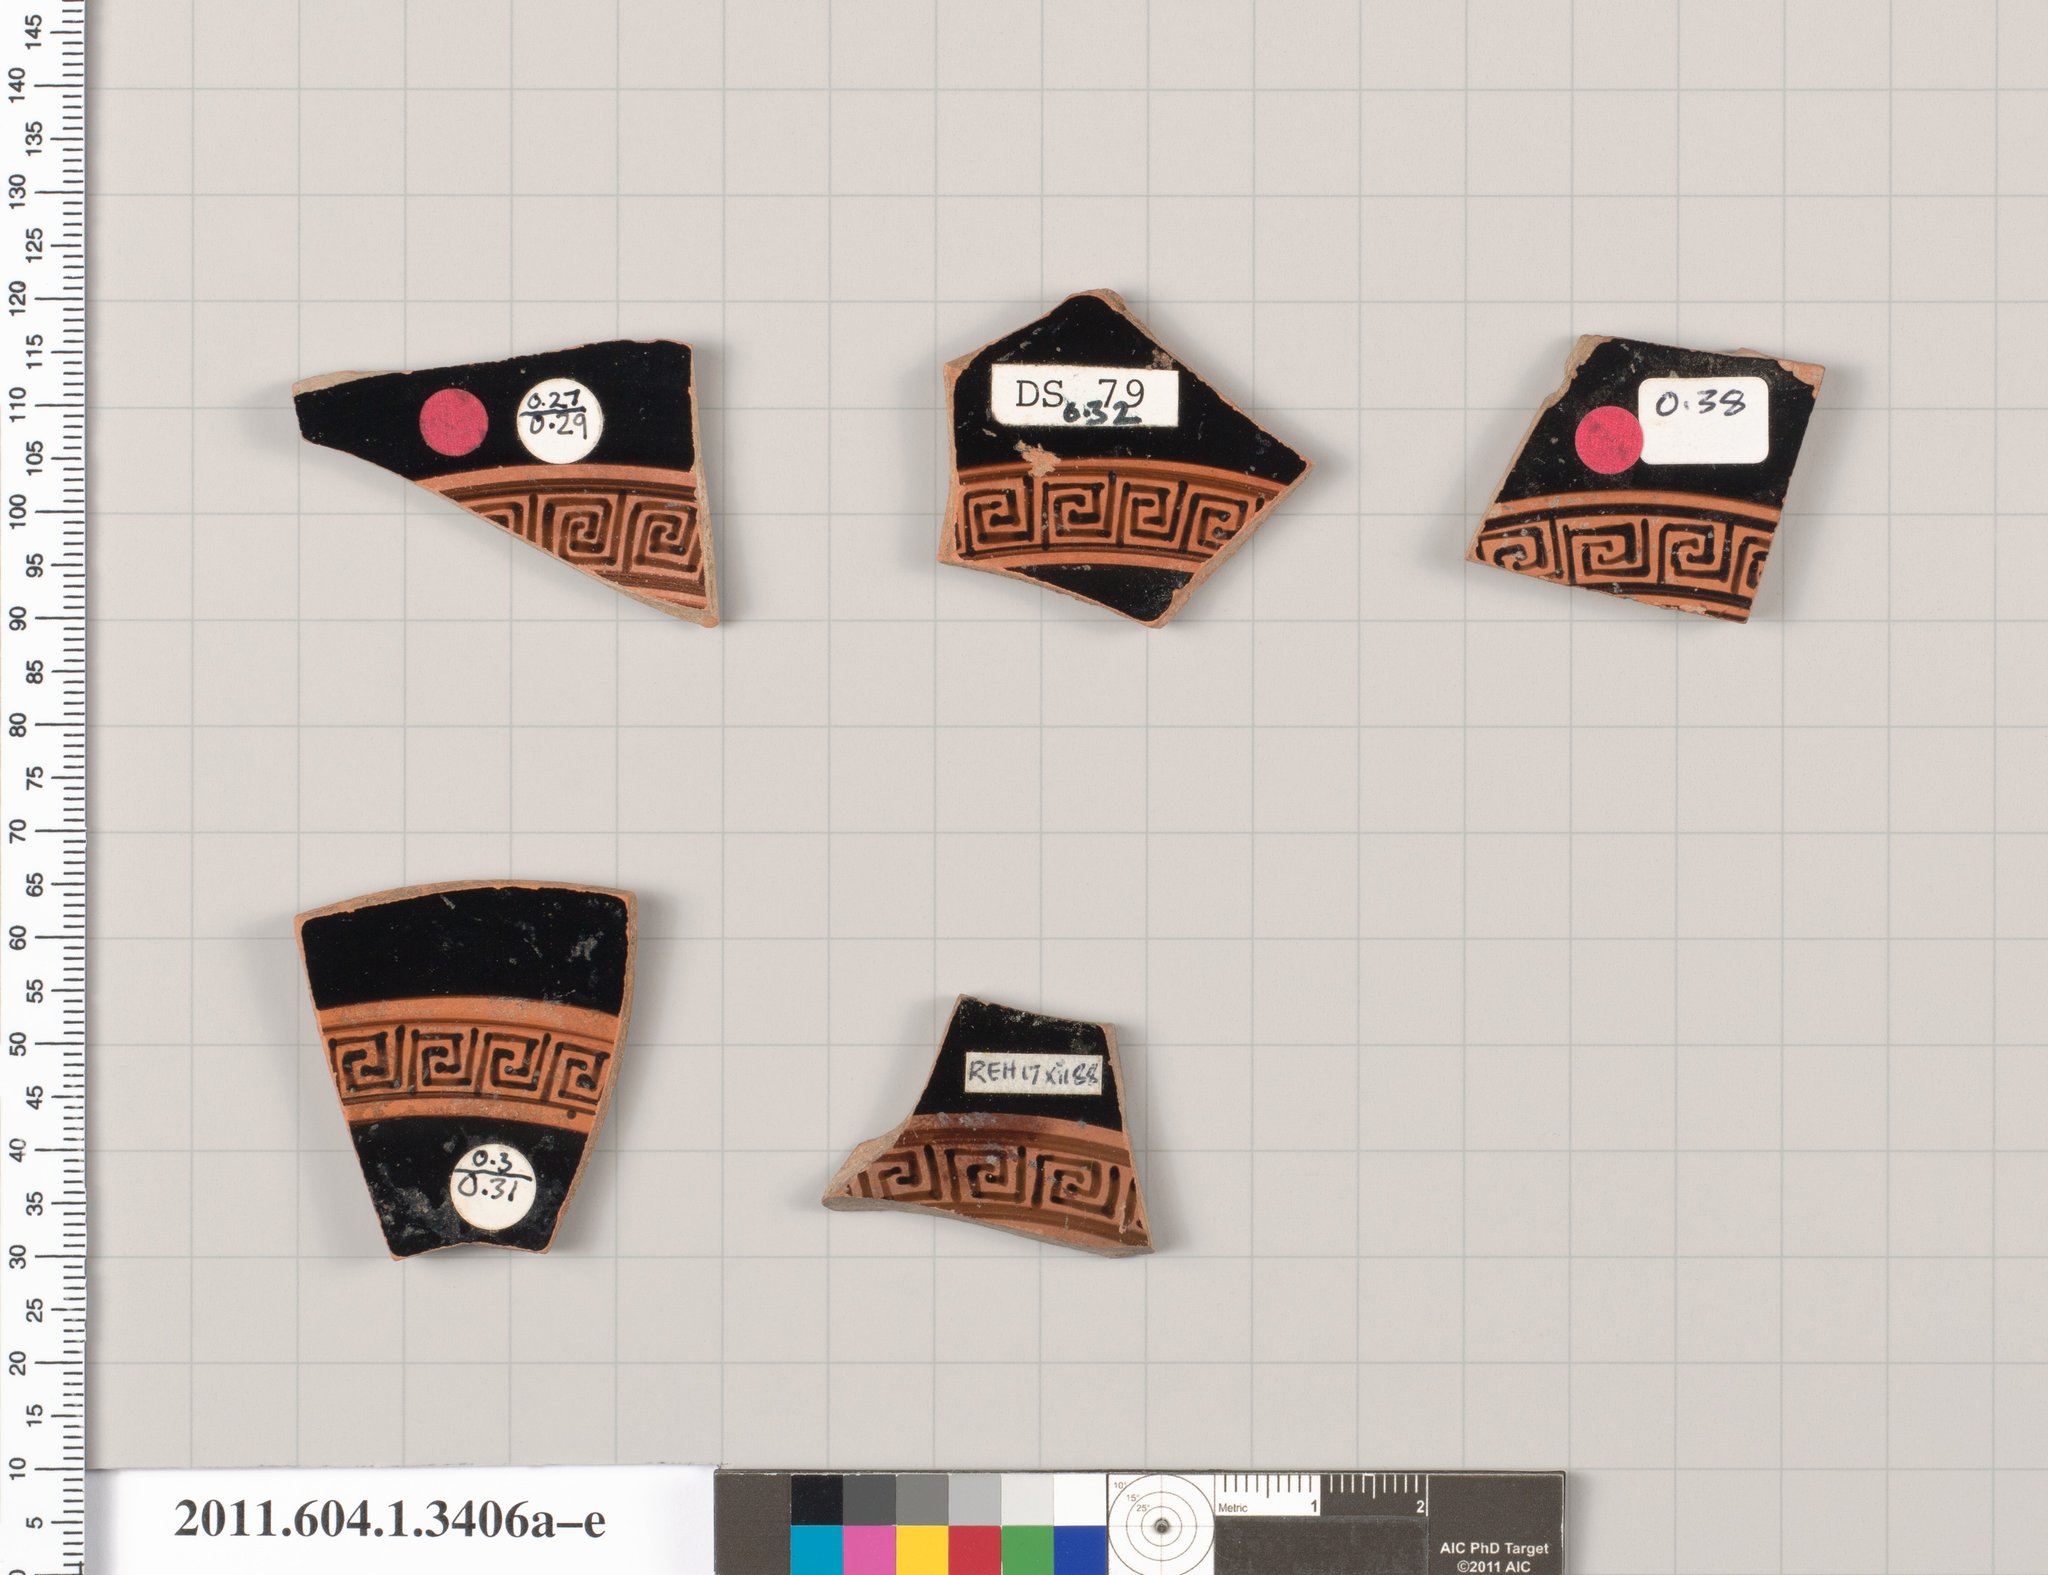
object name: kylix fragment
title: Terracotta fragments of kylikes (drinking cups)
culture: greek, attic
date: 510-470 BCE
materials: terracotta